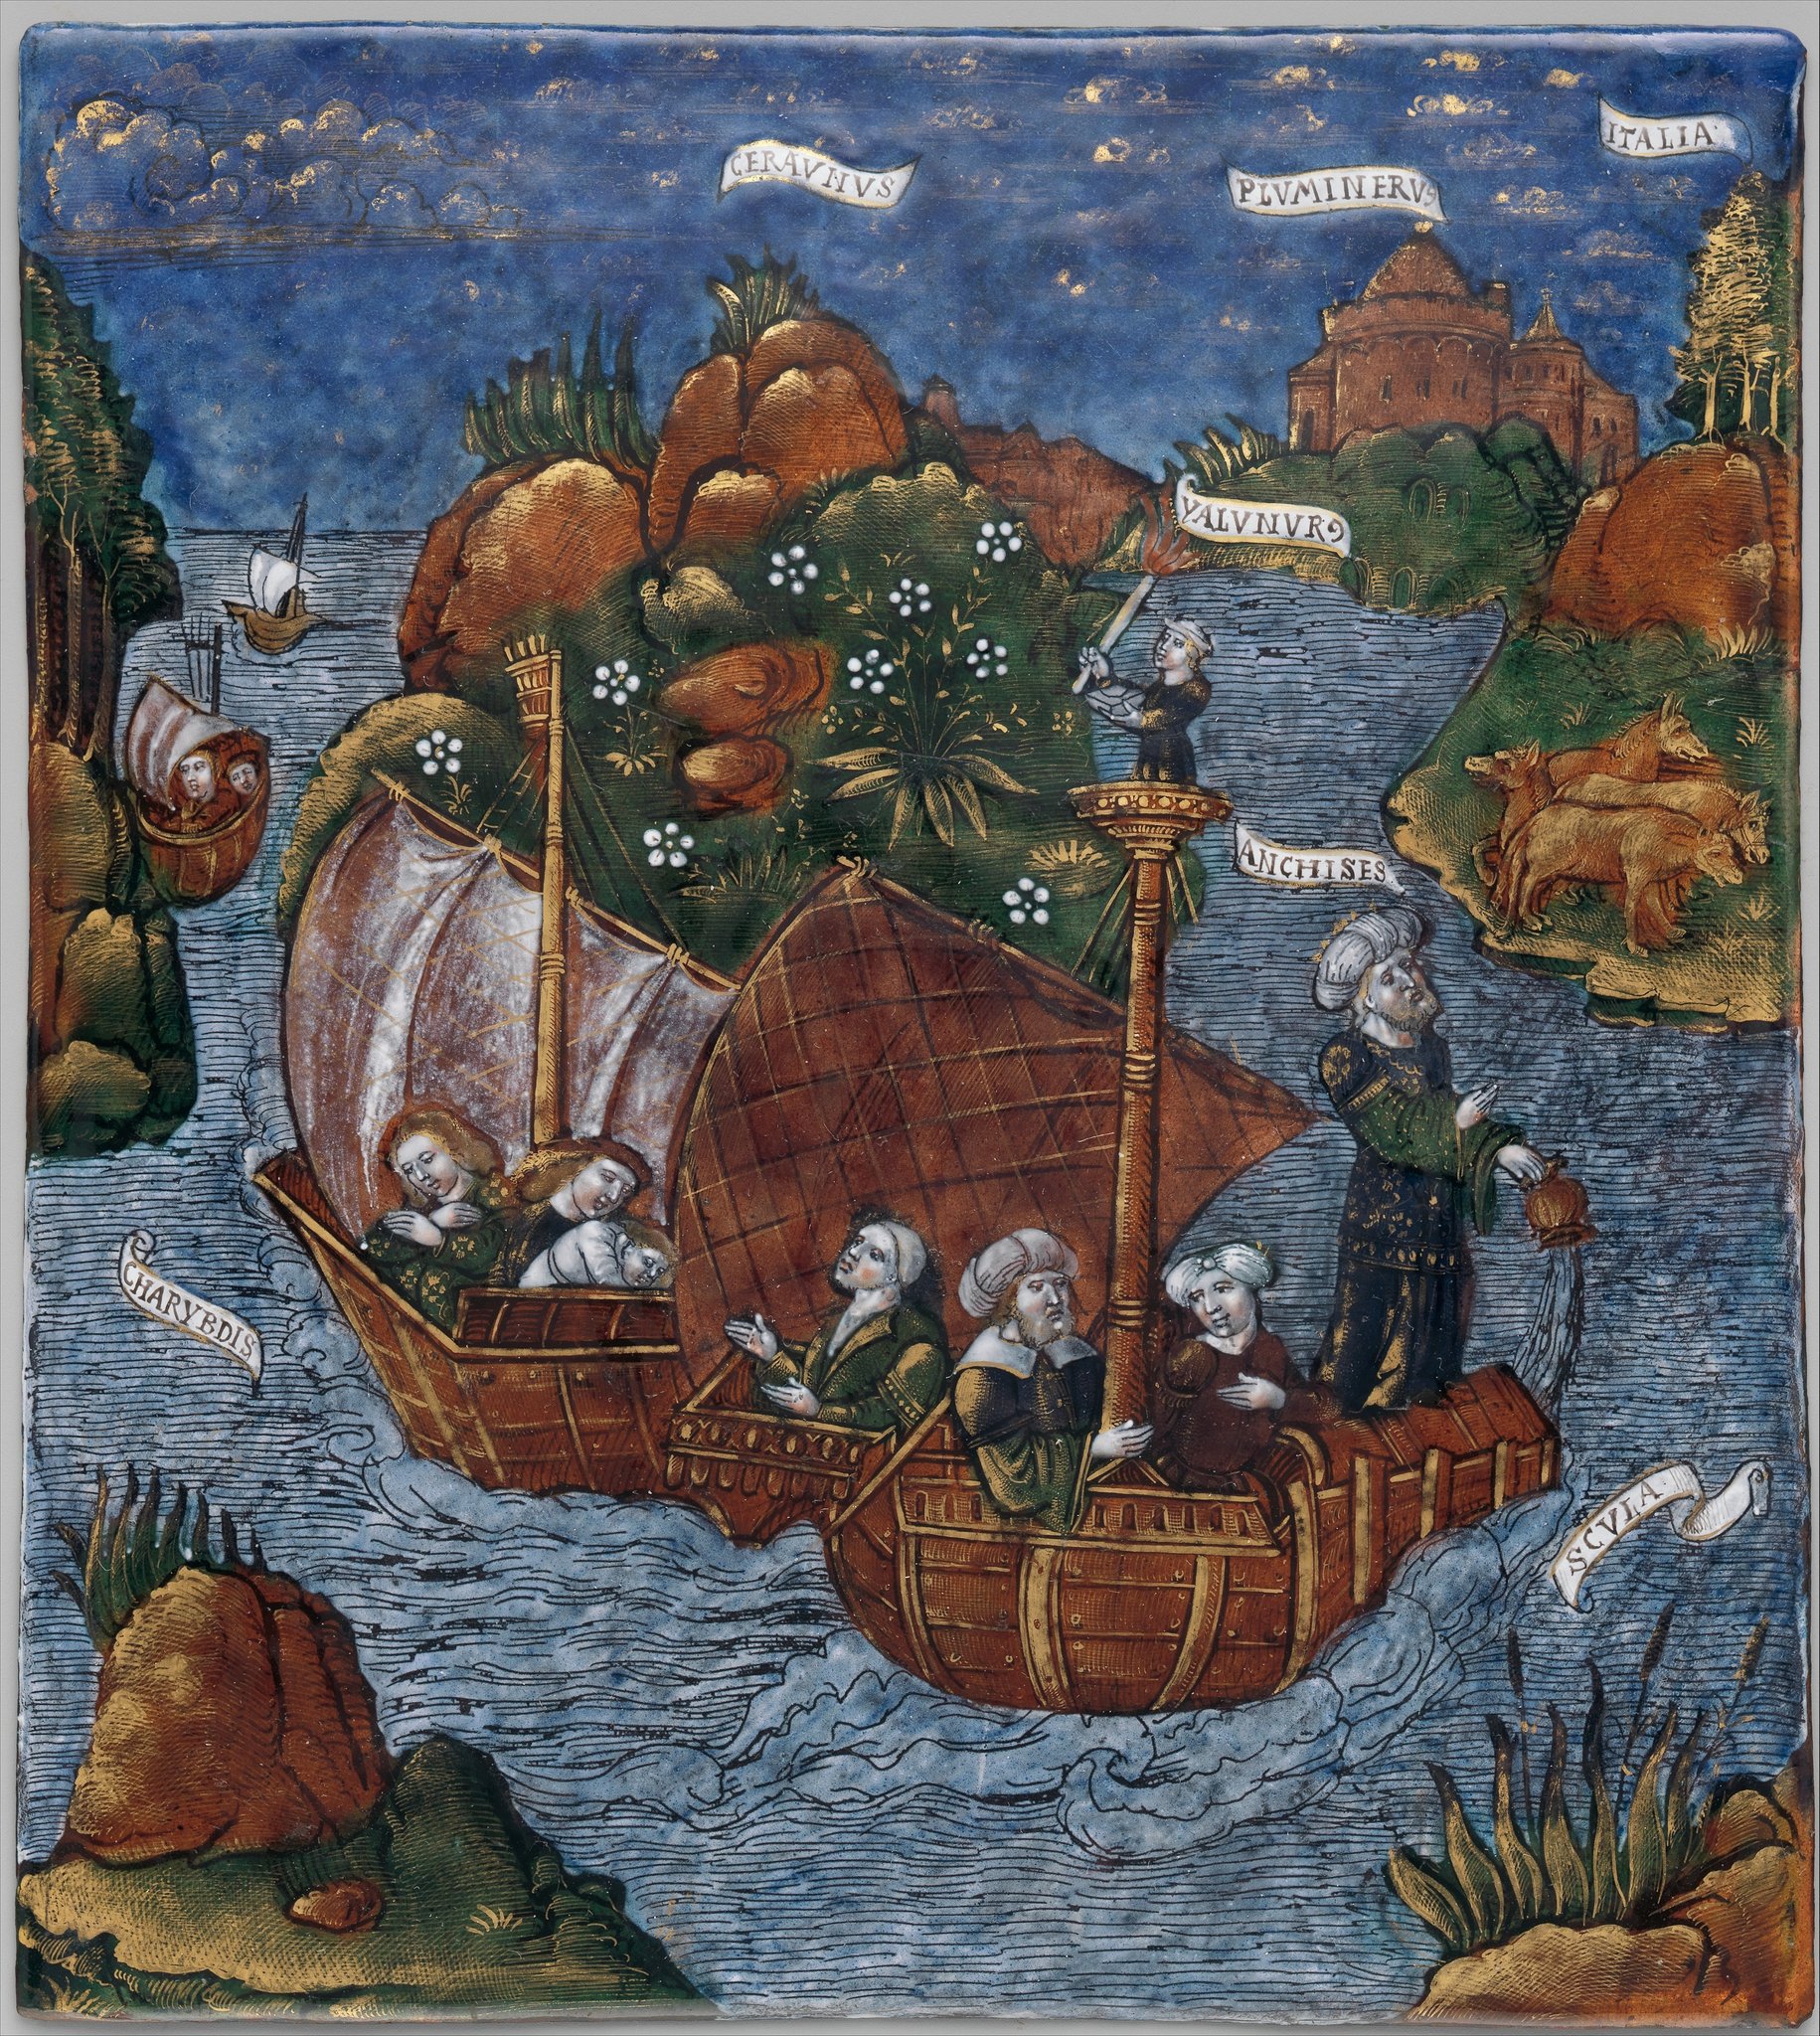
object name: plaque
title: The Fleet of Aeneas Arrives in Sight of Italy (Aeneid, Book III)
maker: master of the aeneid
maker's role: artist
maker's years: 1525-1545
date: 1530-1535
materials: copper, enamel, gilt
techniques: painting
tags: animals,men,women,trees,boats